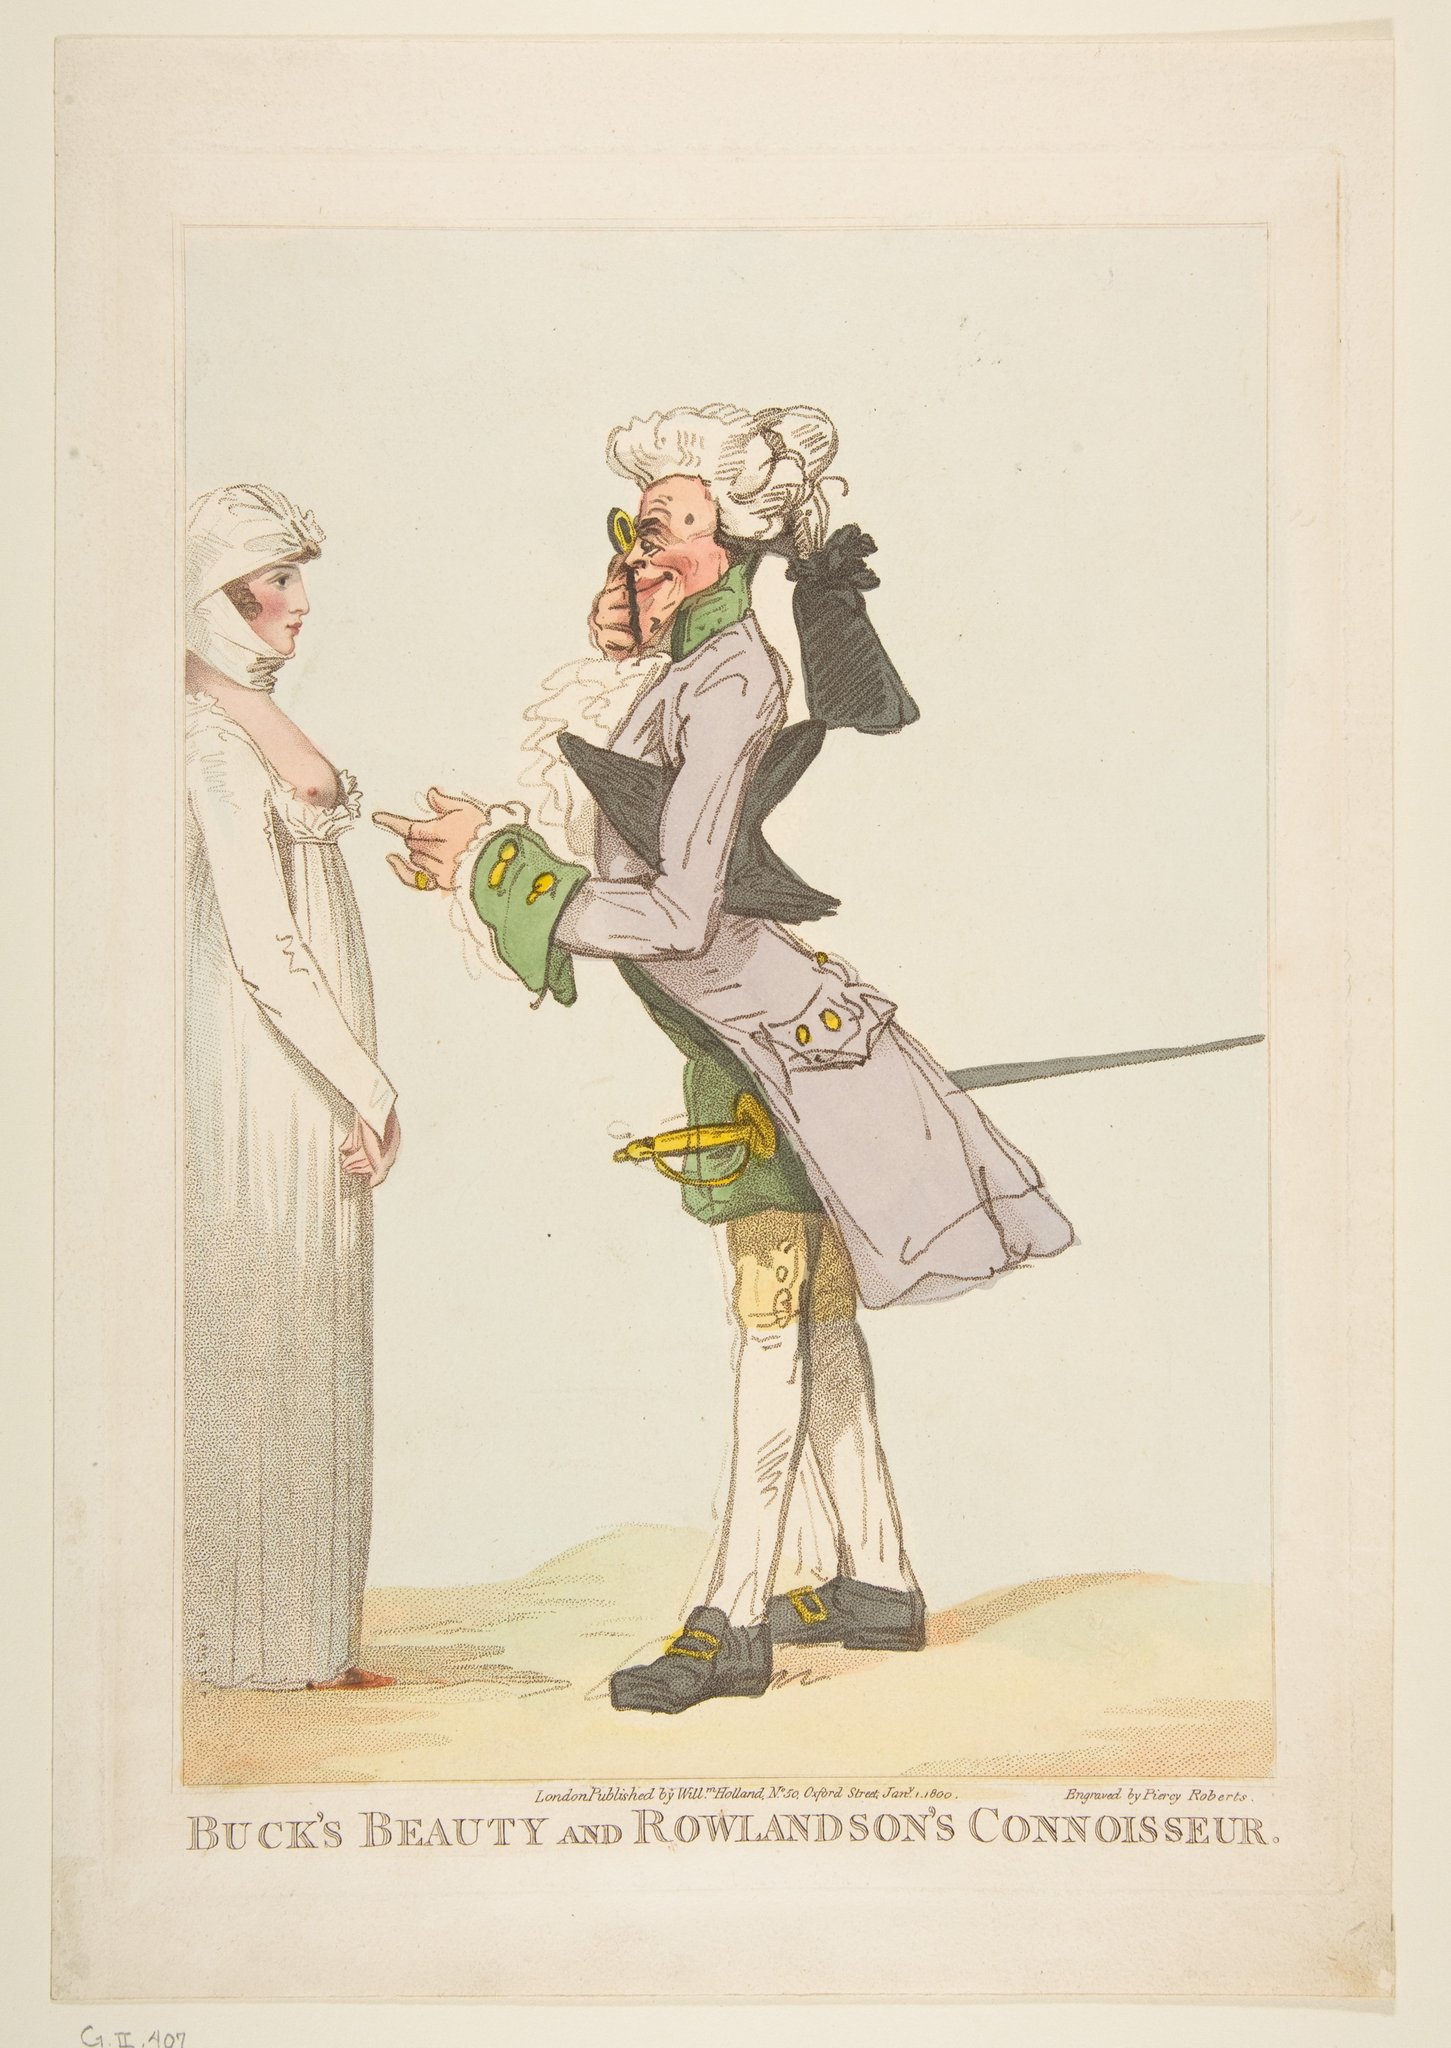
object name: print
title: Buck's Beauty and Rowlandson's Connoisseur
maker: piercy roberts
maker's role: artist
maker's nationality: british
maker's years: 1795-1827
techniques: etching, engraving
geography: london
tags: men,female nudes